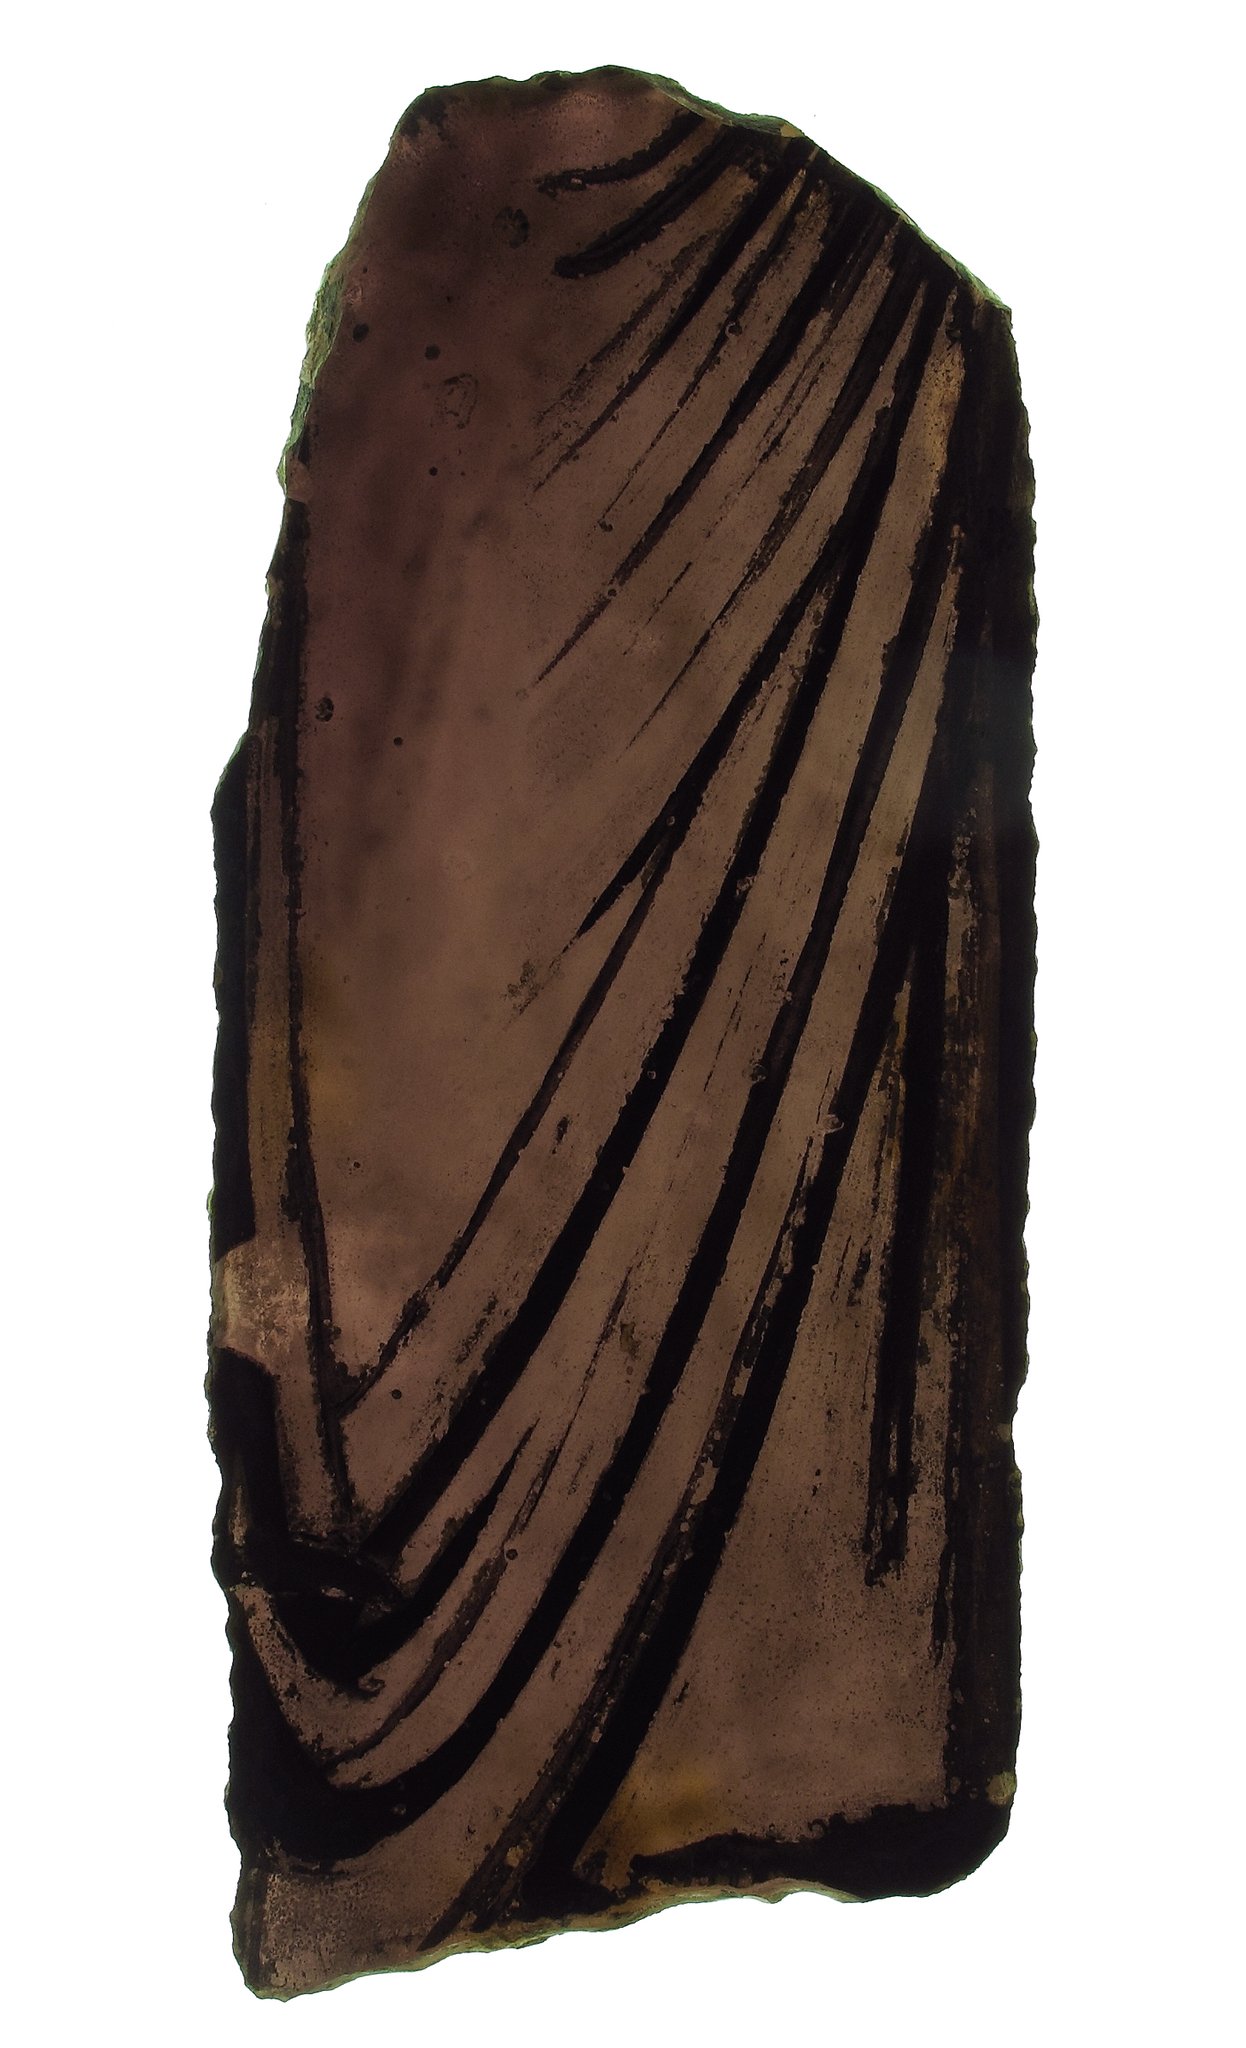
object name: fragment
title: Glass Fragment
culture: european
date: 1167-1233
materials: glass, metal